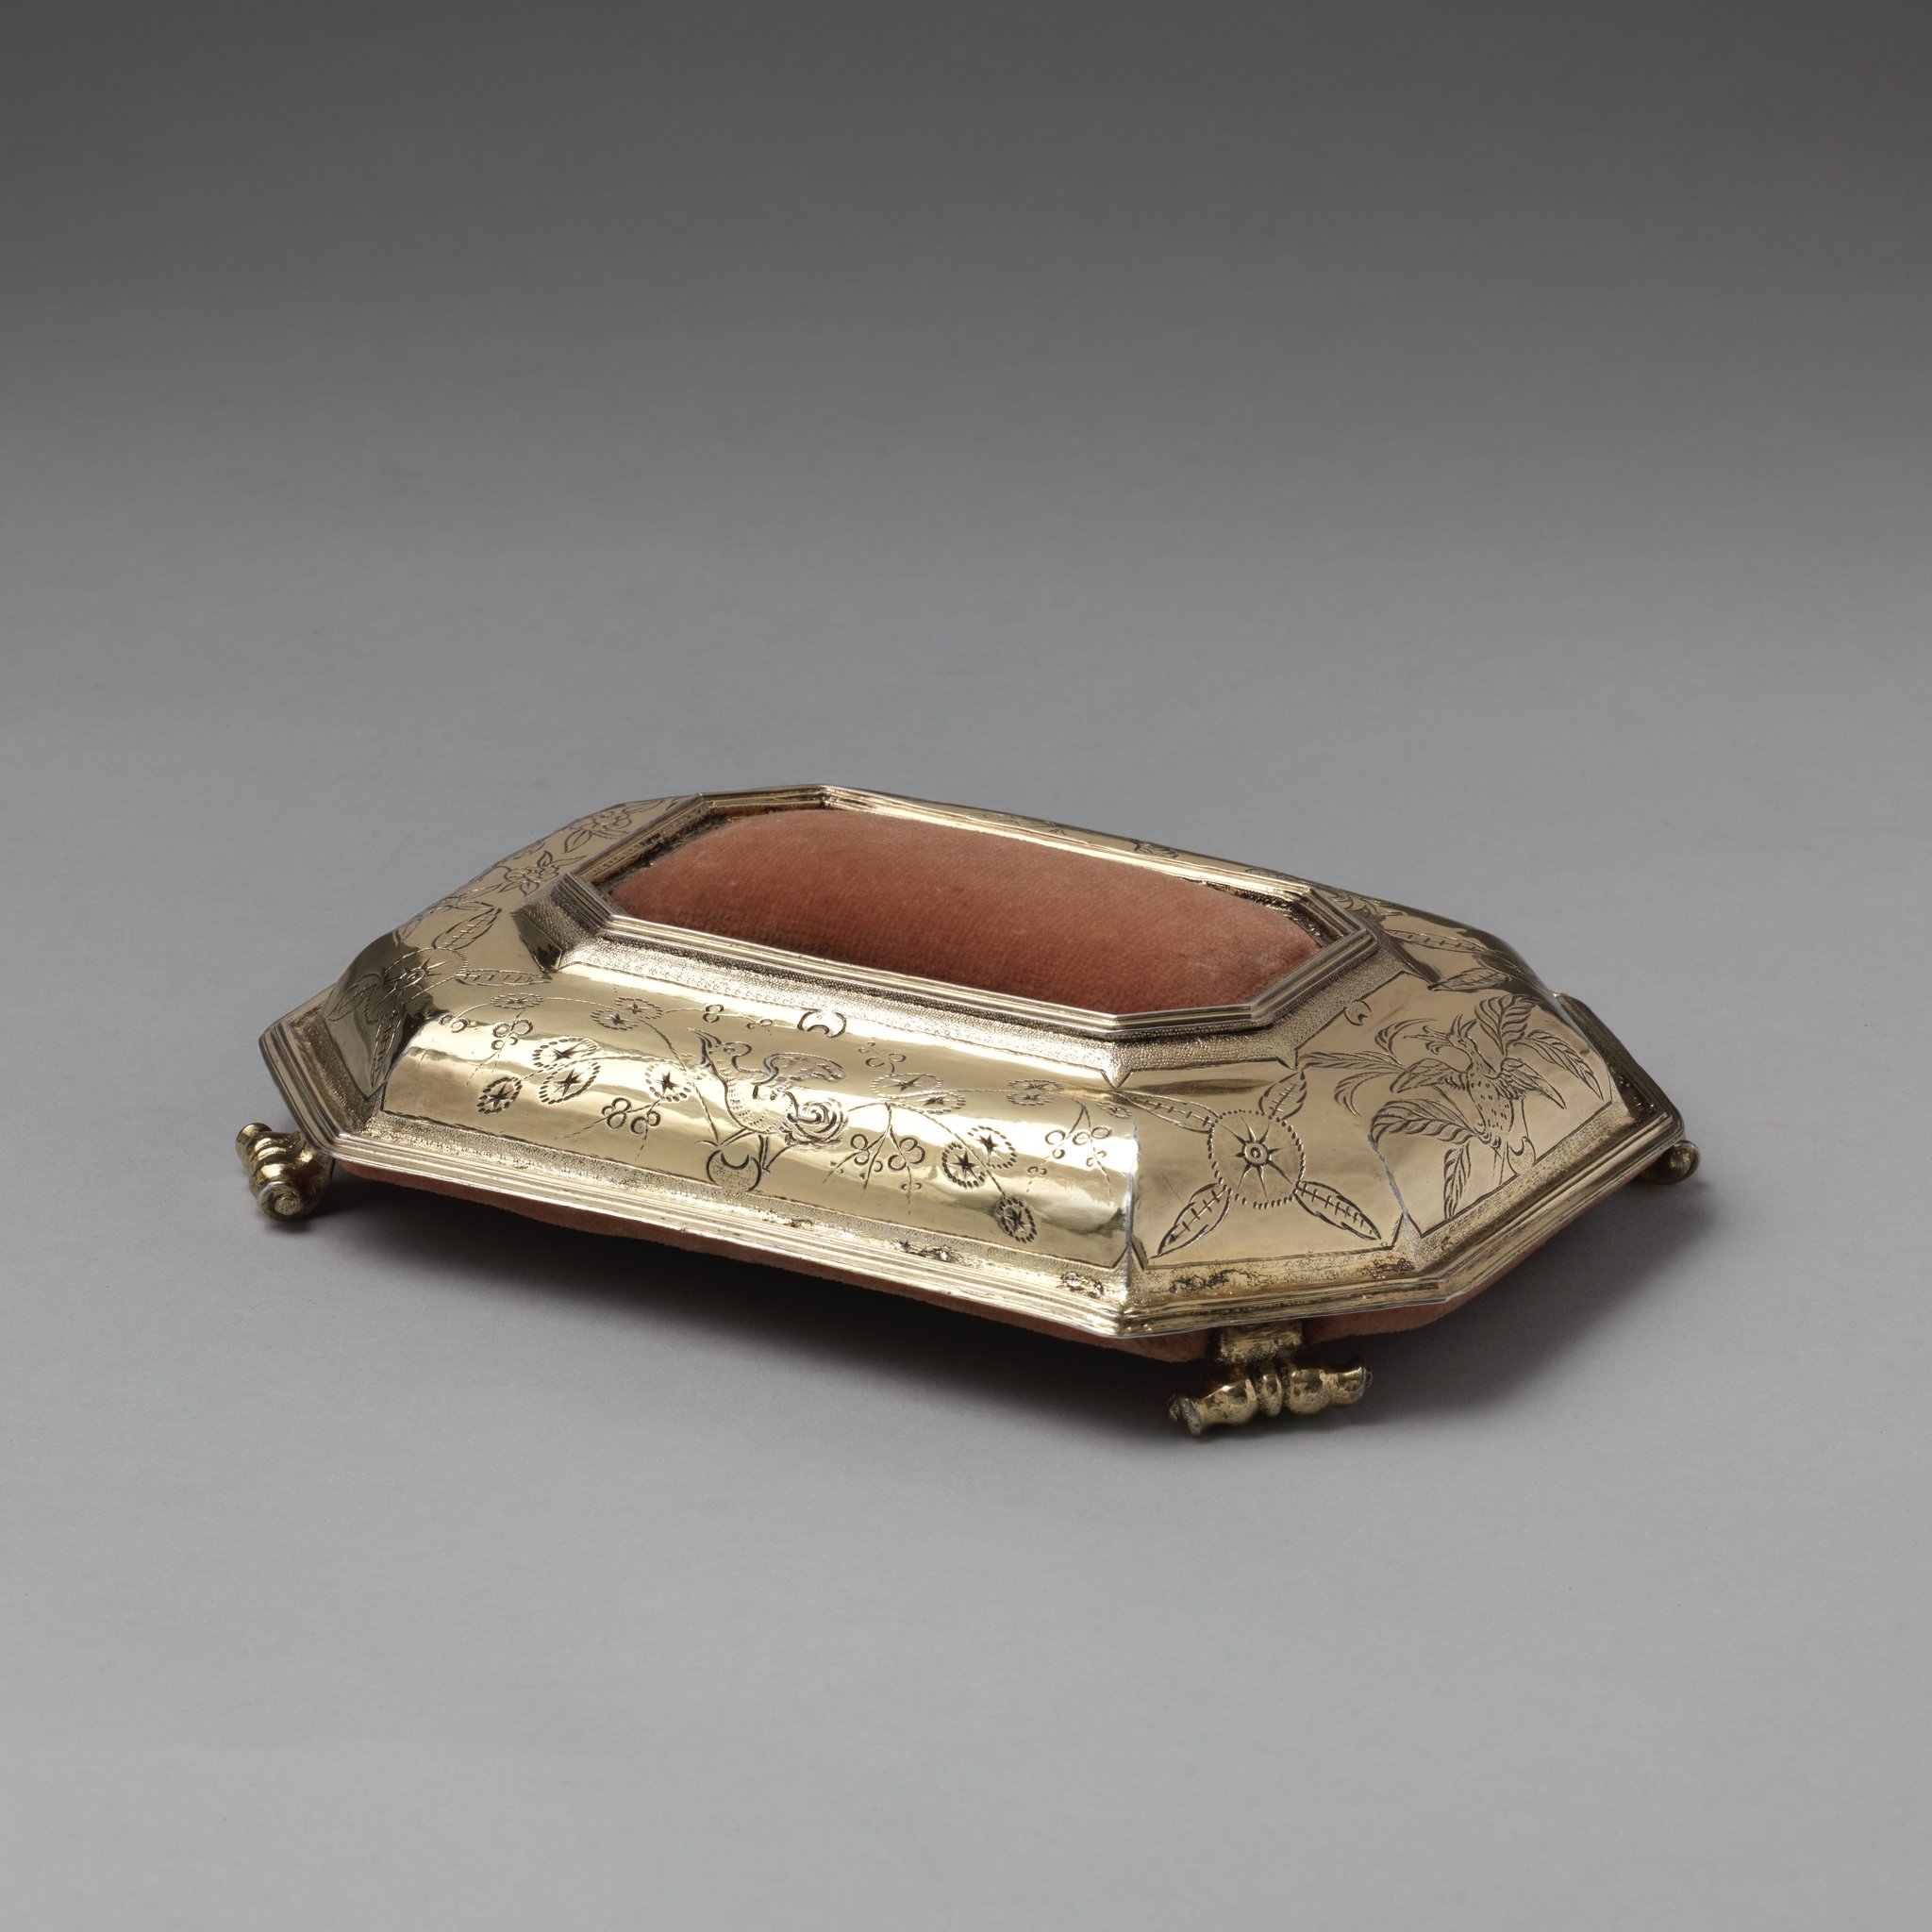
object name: pincushion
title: Pin cushion (part of a toilet service)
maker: d., london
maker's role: maker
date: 1687-1688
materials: silver gilt